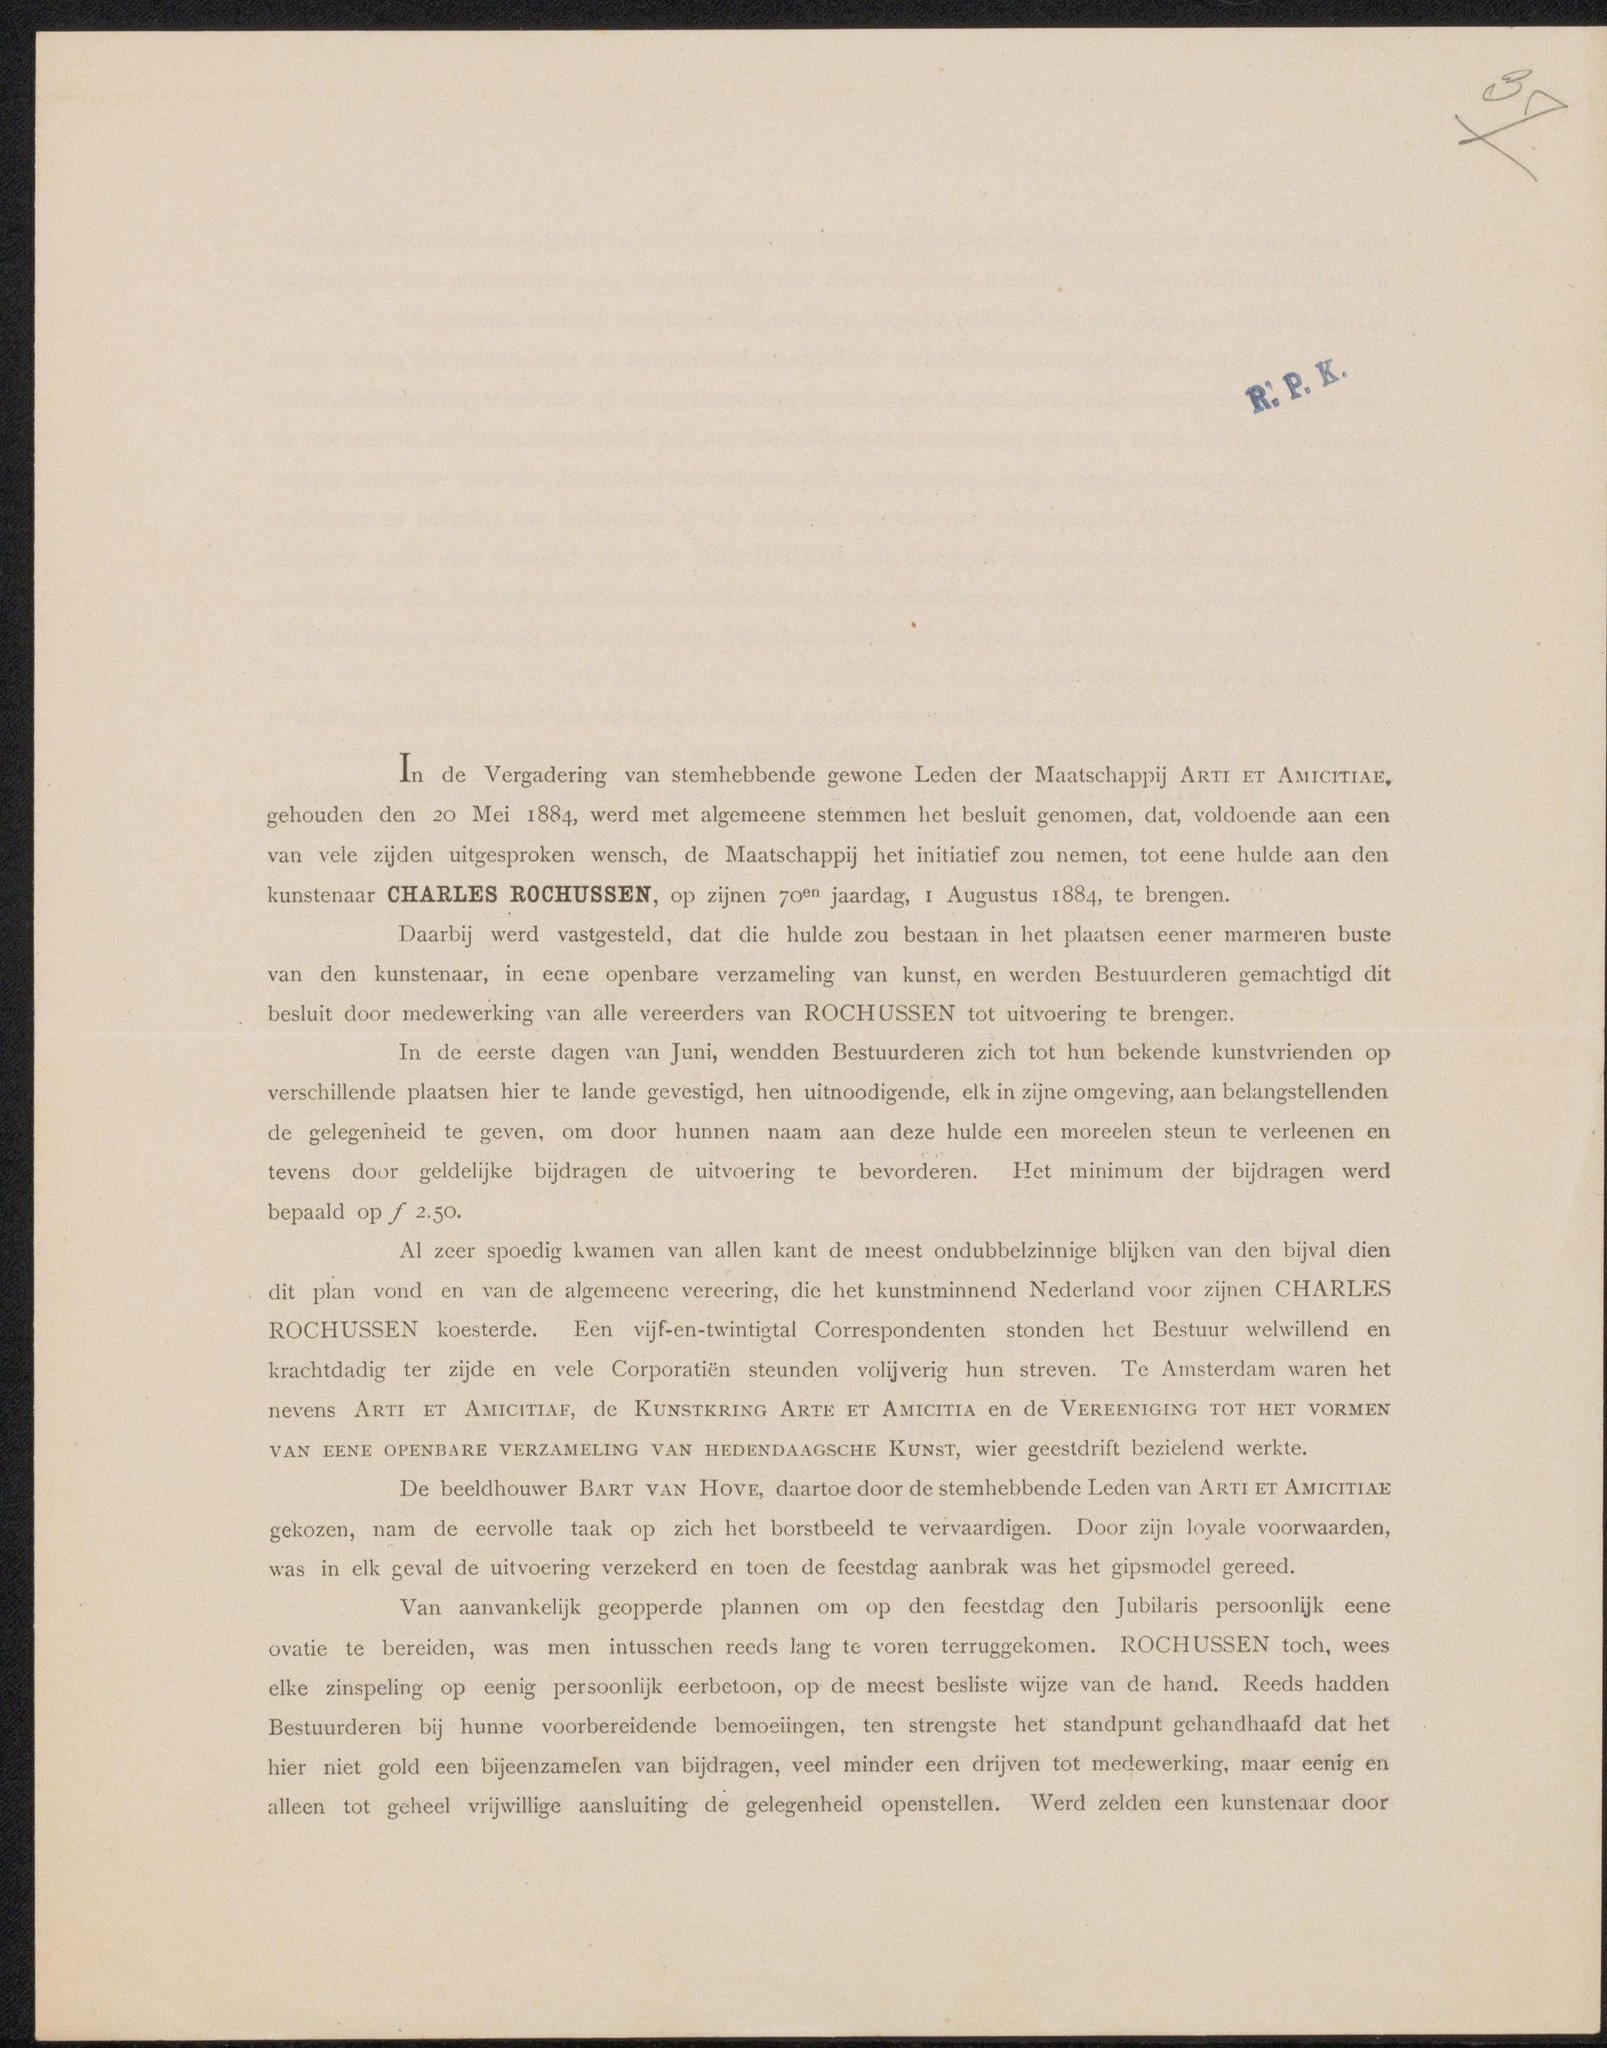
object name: verslag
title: Verslag van de huldiging van Charles Rochussen voor zijn zeventigste verjaardag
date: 1884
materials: ink, paper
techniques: printing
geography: amsterdam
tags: rotterdam, print maker, draughtsman, charles rochussen, sculpture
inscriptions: collector's mark: Lugt 2233